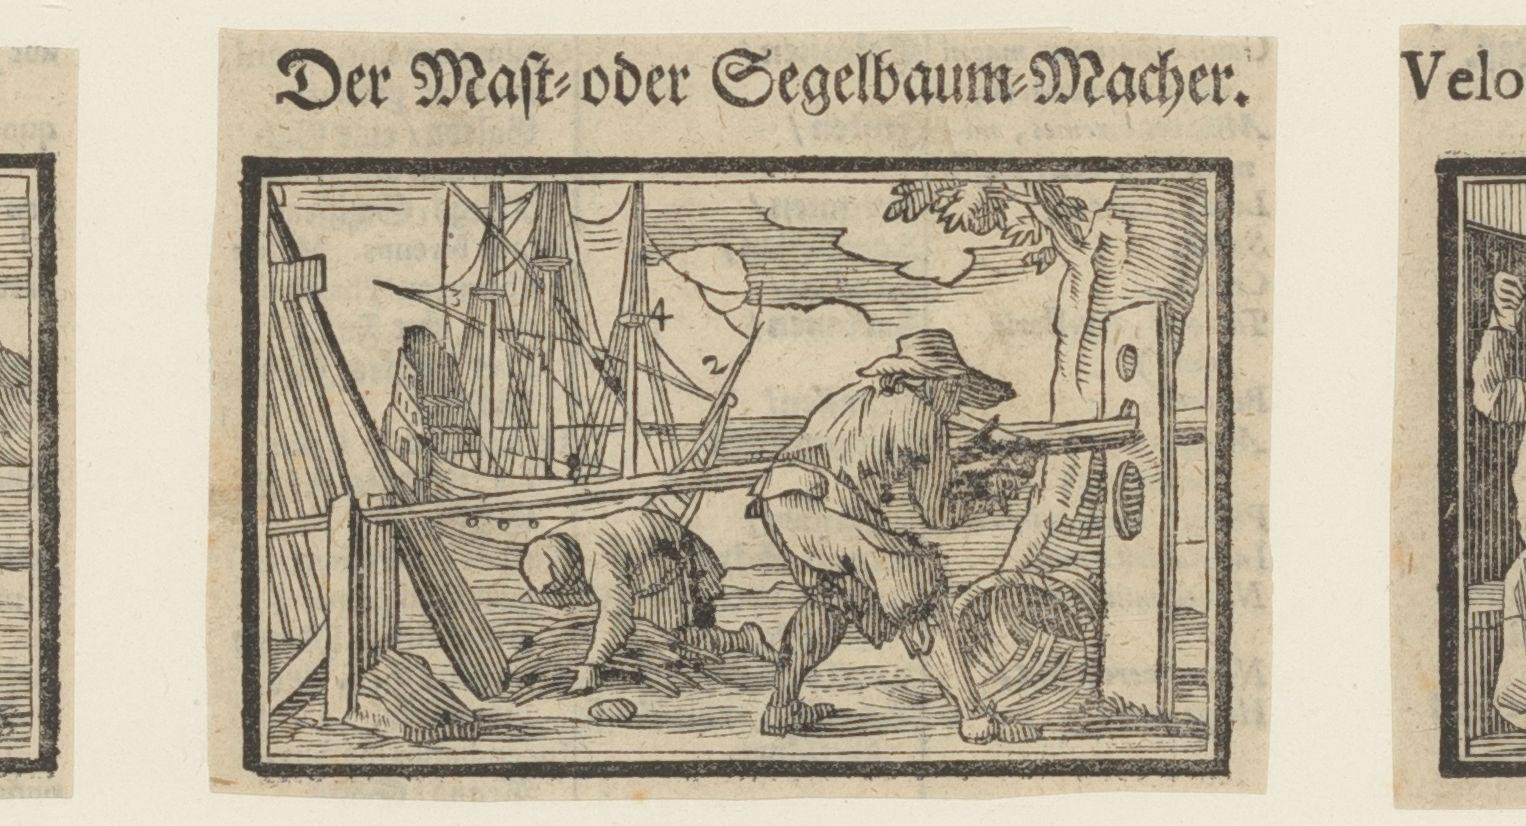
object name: print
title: Mastenmaker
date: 1719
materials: paper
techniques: letterpress printing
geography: nuremberg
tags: ship's carpenter, handicrafts, craftsman at work, shipyard-workers, shipbuilding industry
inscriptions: stamp, collector's mark: Lugt 1641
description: Op de voorgrond bewerkt een mastenmaker een mast met een schaaf. Op de achtergrond een schip ter illustratie van de verschillende masten, bomen en gieken. Onderwerpsrubrieken binnen de Atlas Zeden en Gewoonten: Handel, Nijverheid en Verkeer, Beroep en bedrijf, Complete suites.